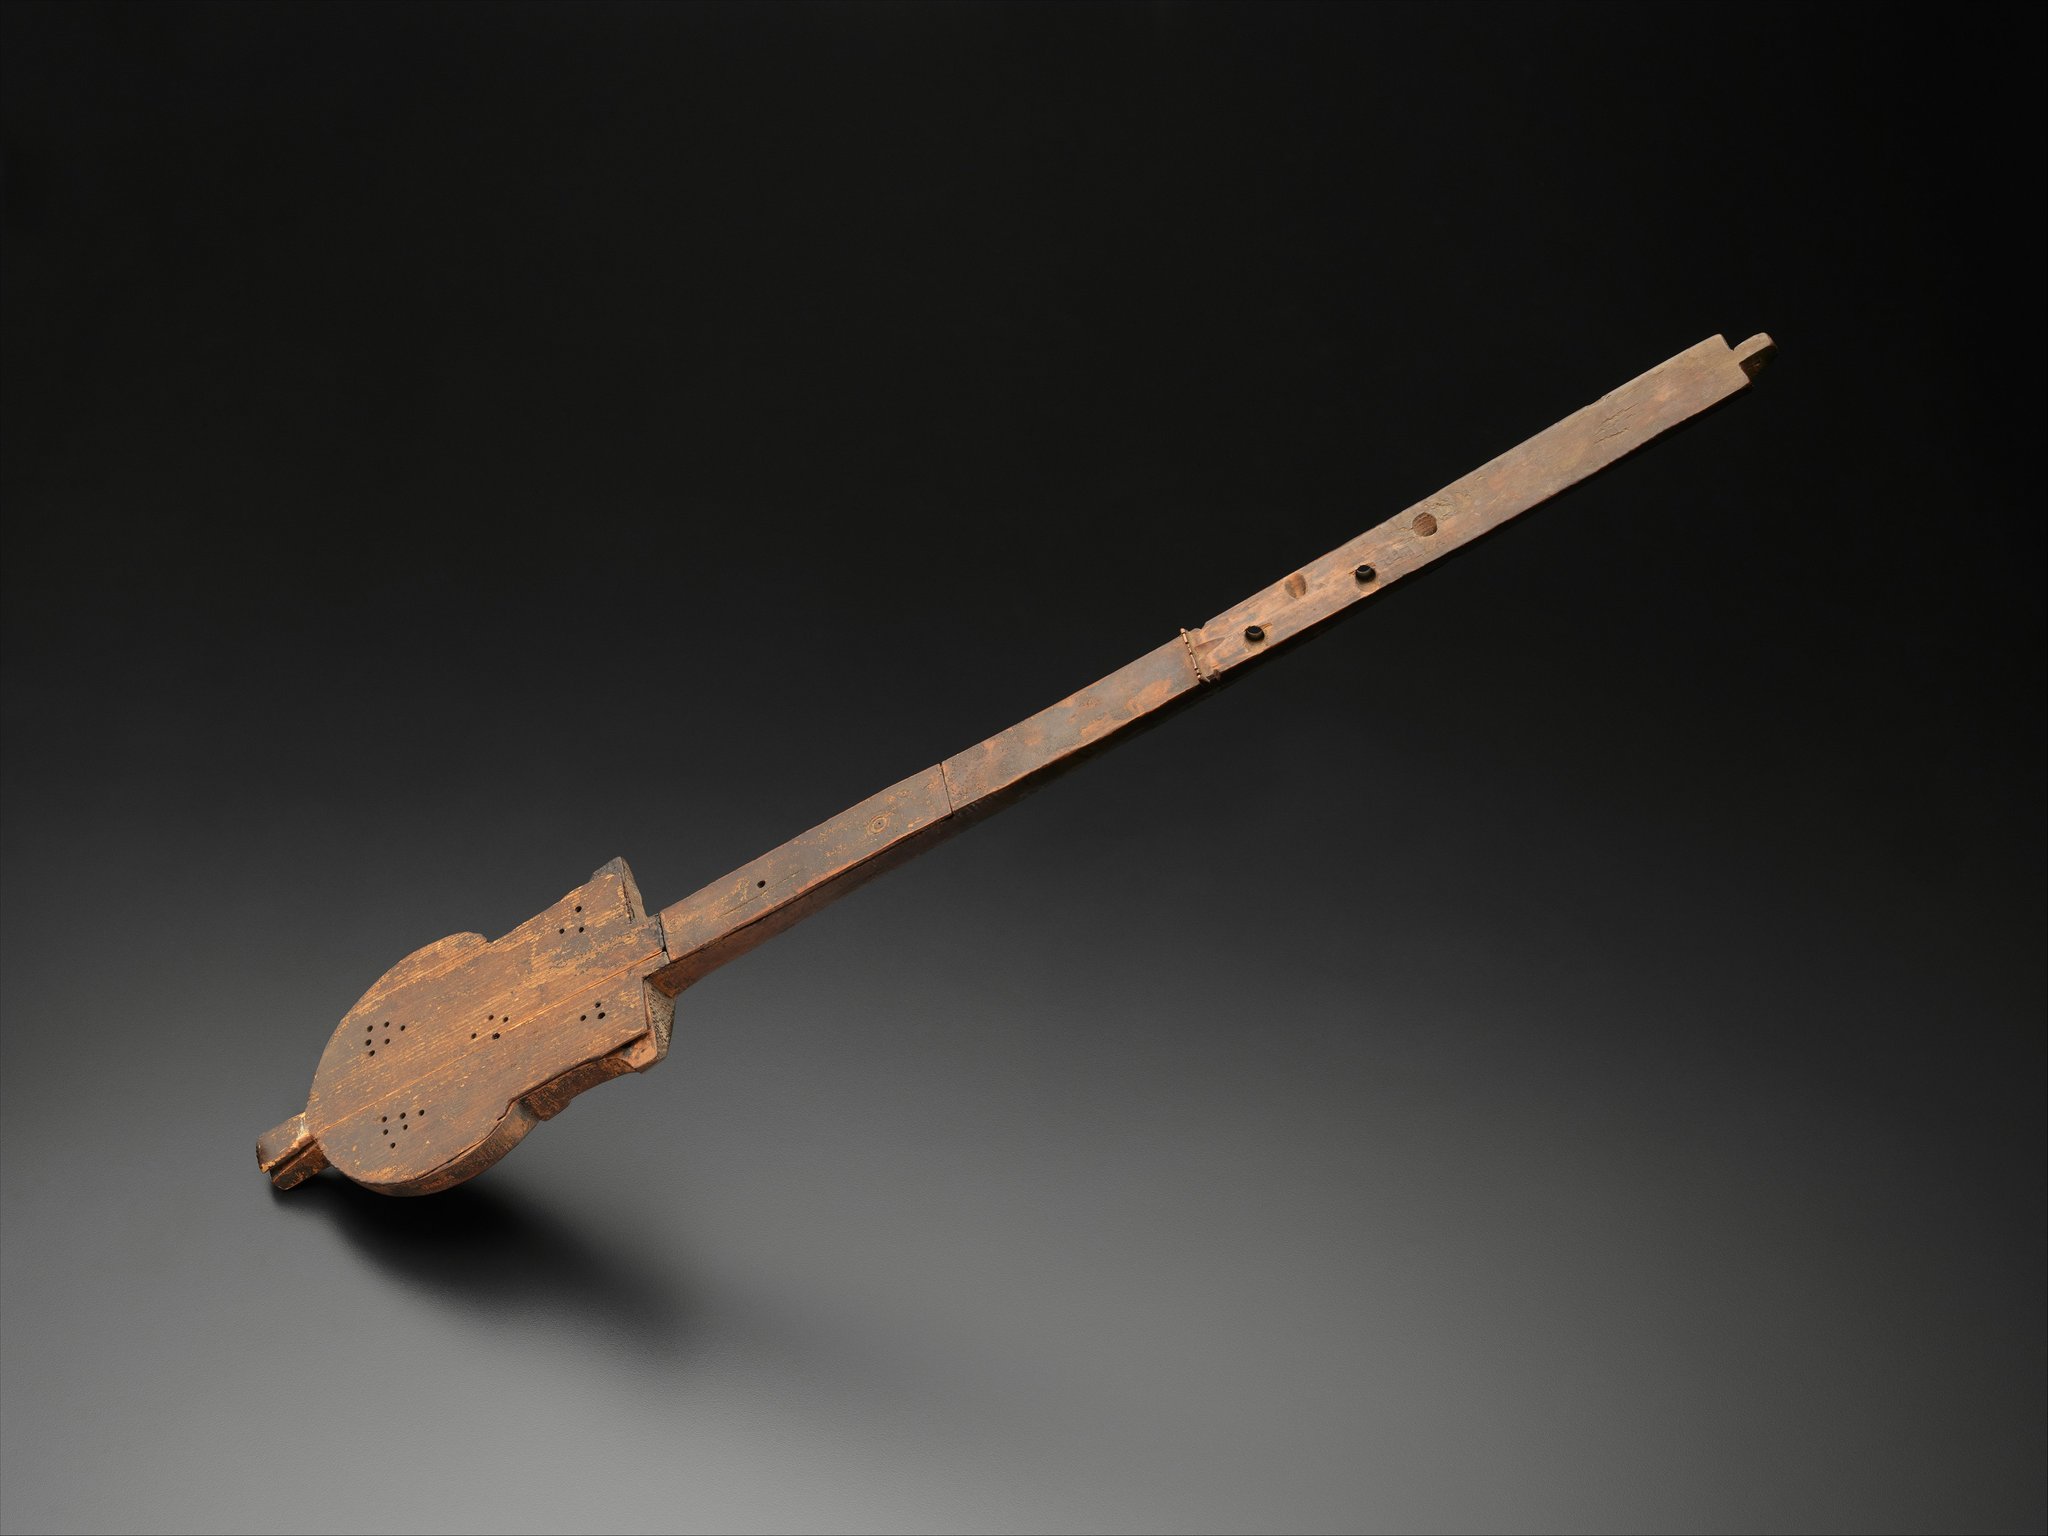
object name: lute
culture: byzantine or roman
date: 200-500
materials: paint, wood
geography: egypt